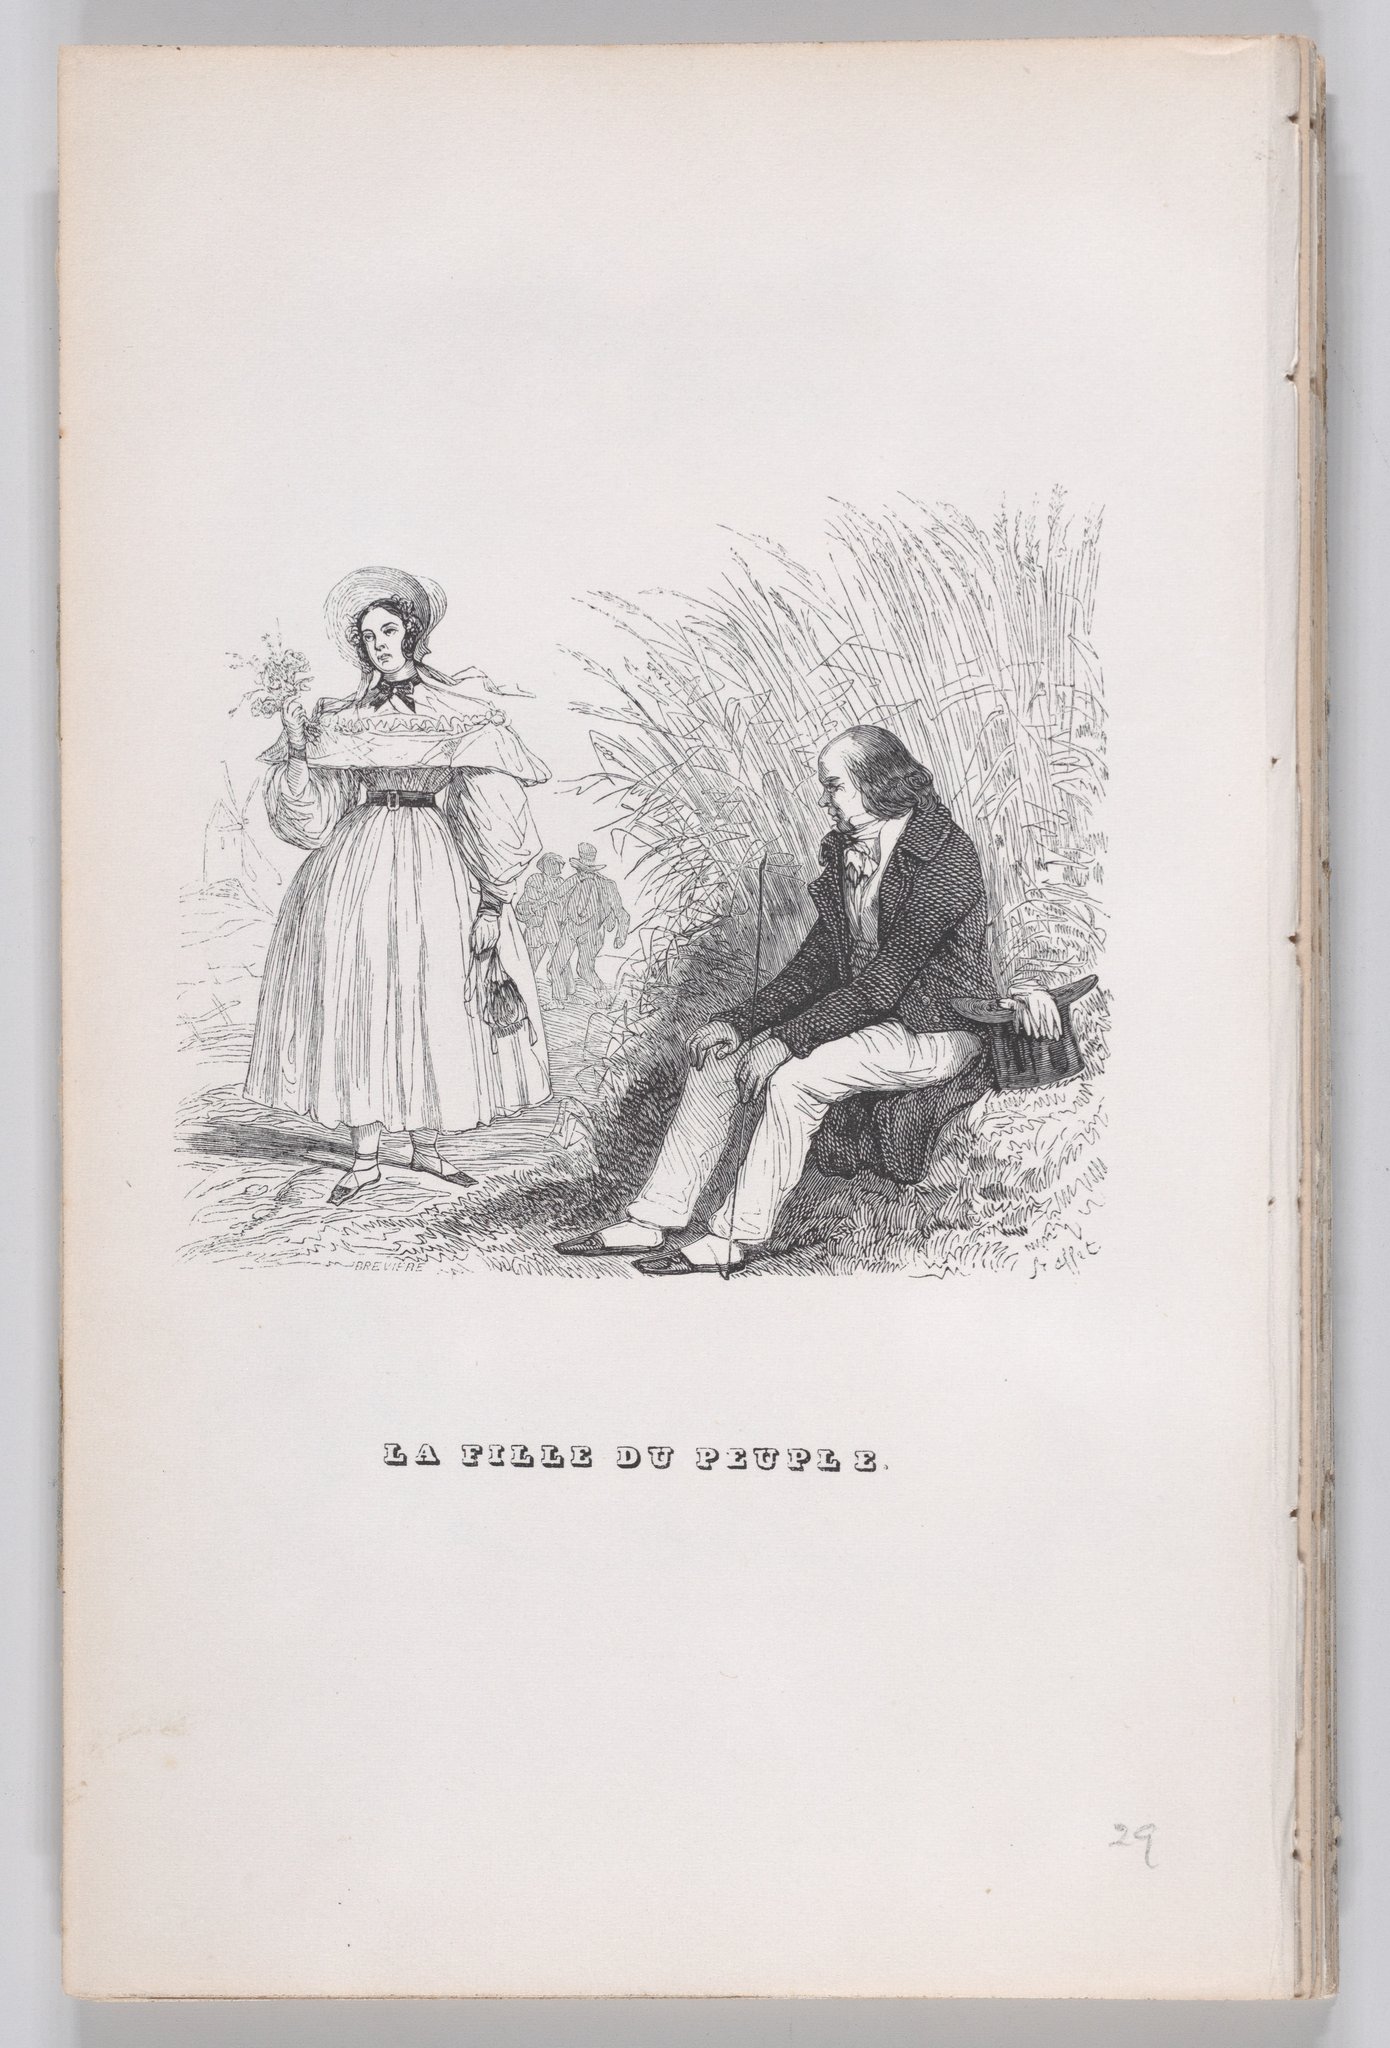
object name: print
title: The Daughter of the People, from "The Complete Works of Béranger"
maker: j. j. grandville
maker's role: illustrator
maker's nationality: french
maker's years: 1803-1847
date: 1836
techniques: engraving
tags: men,women